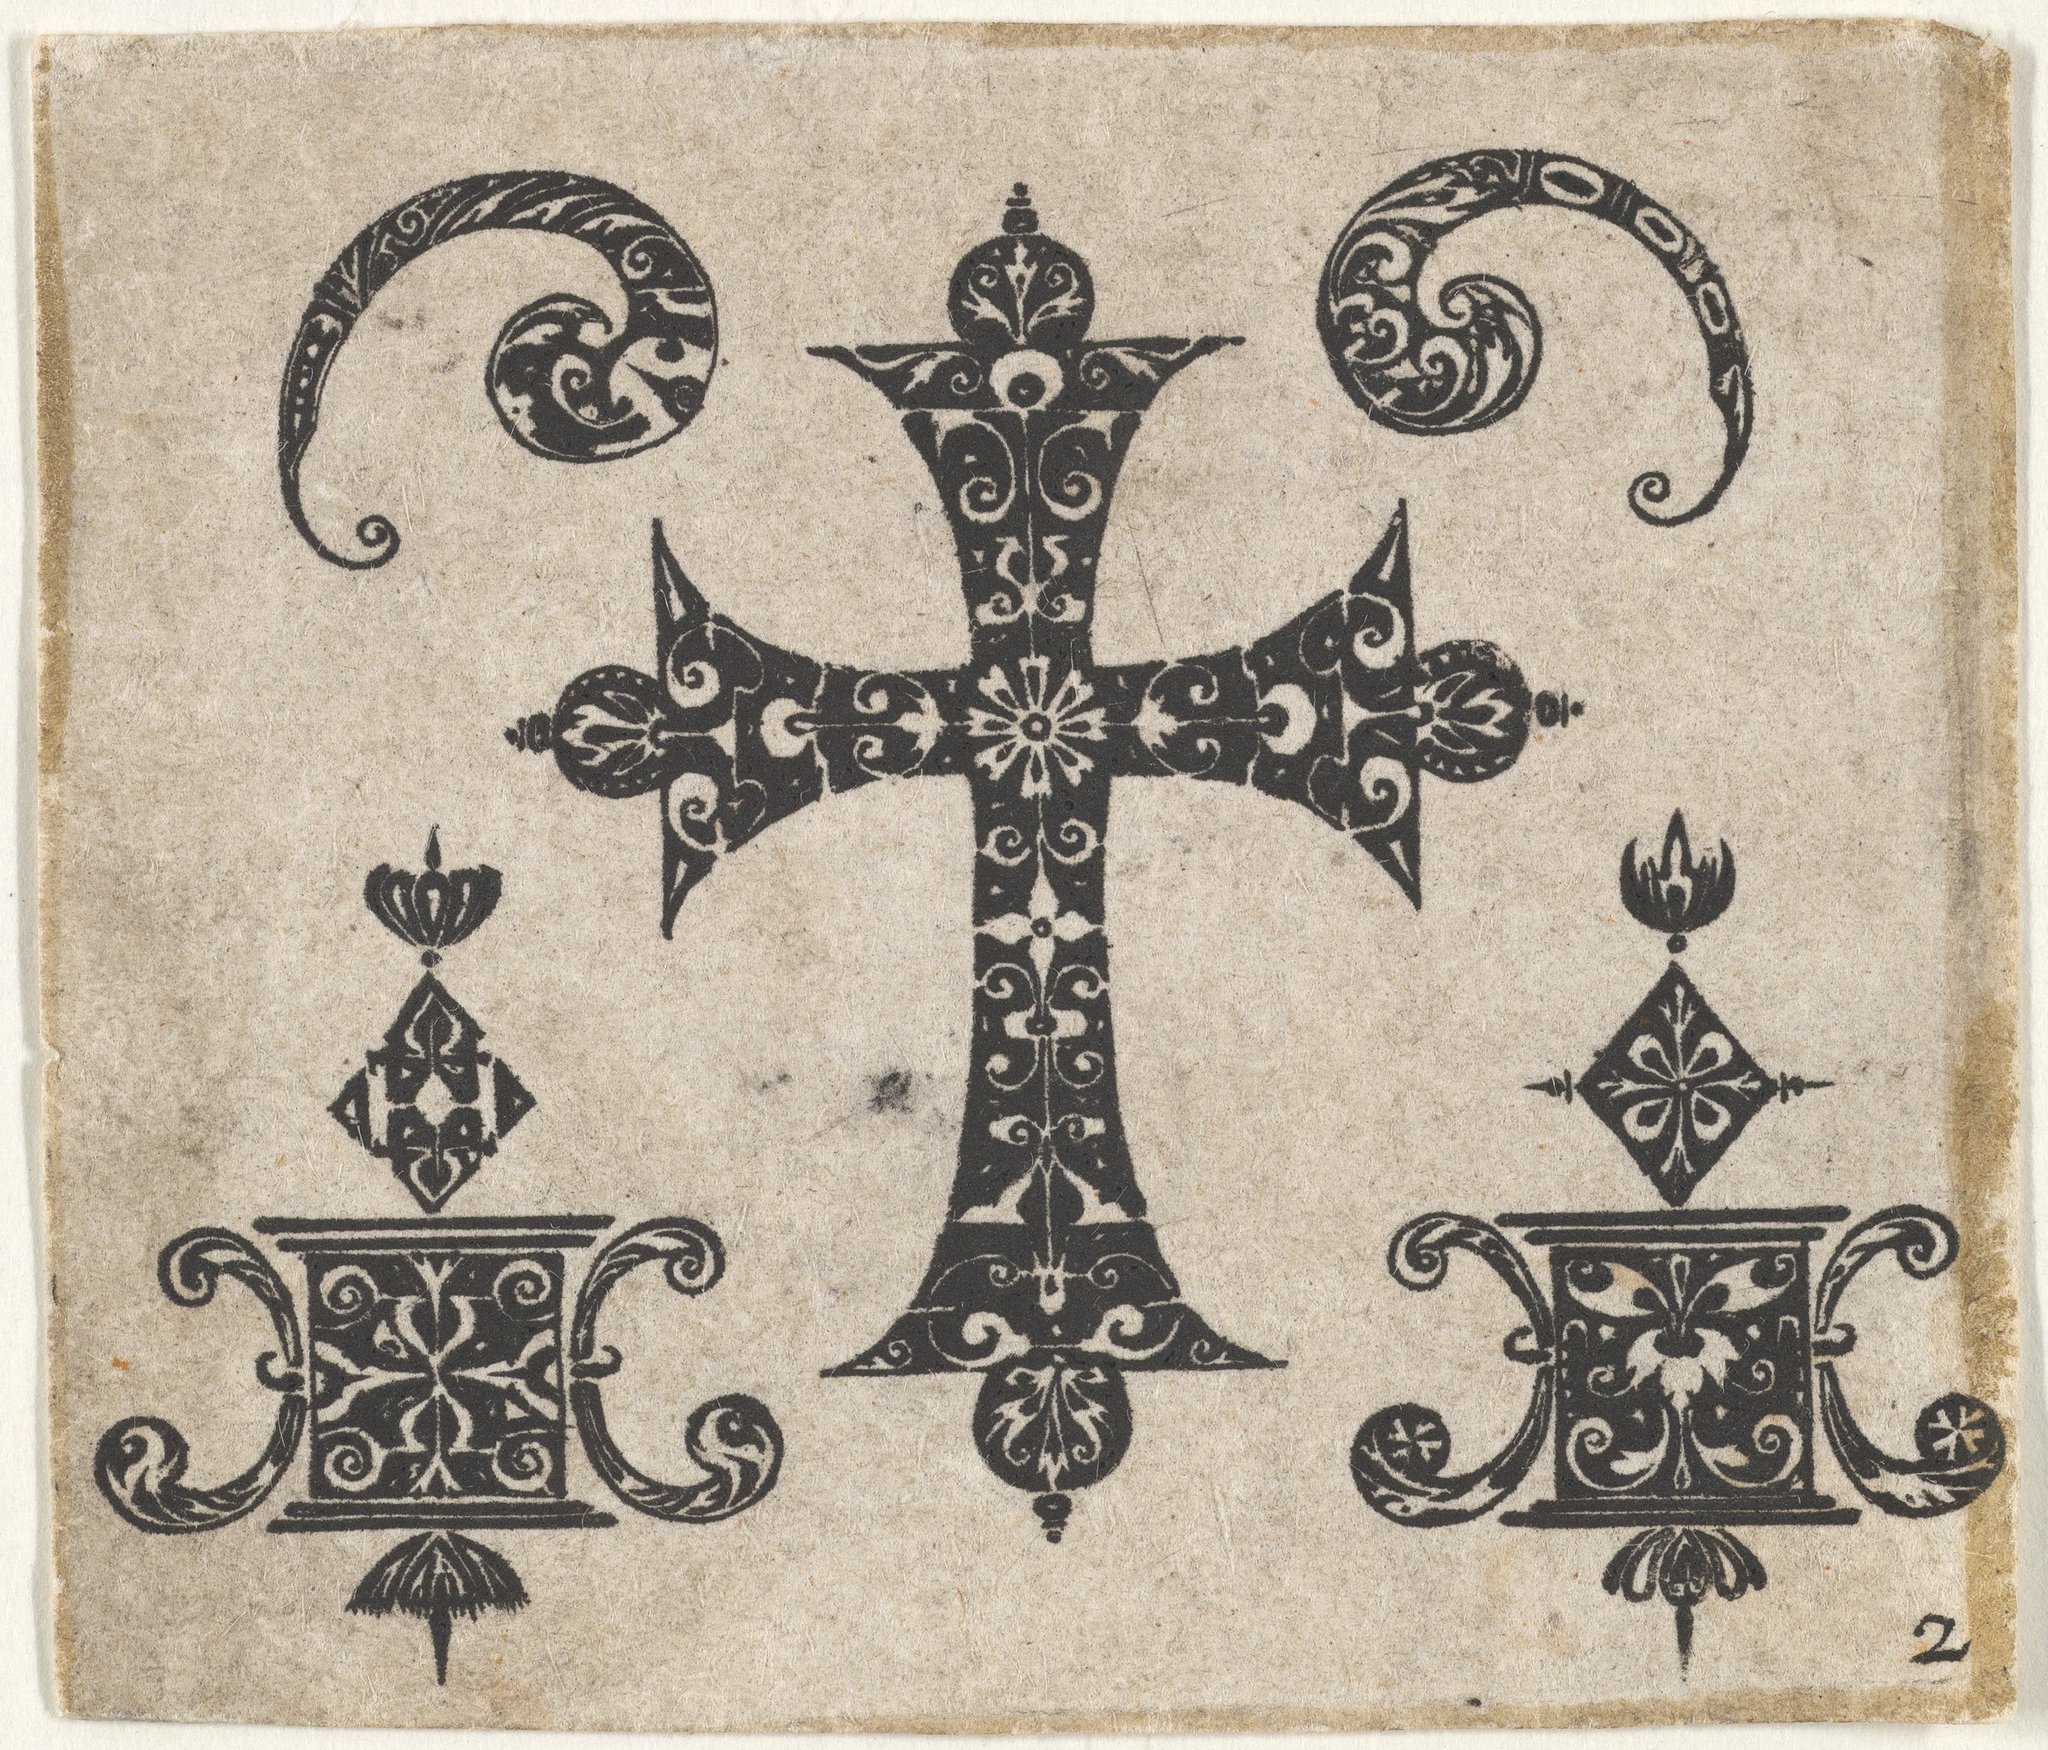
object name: print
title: Blackwork Print with a Latin Cross and Small Motifs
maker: claes jansz. visscher (ii)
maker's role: artist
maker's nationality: dutch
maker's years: 1586-1652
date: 1620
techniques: embroidery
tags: cross